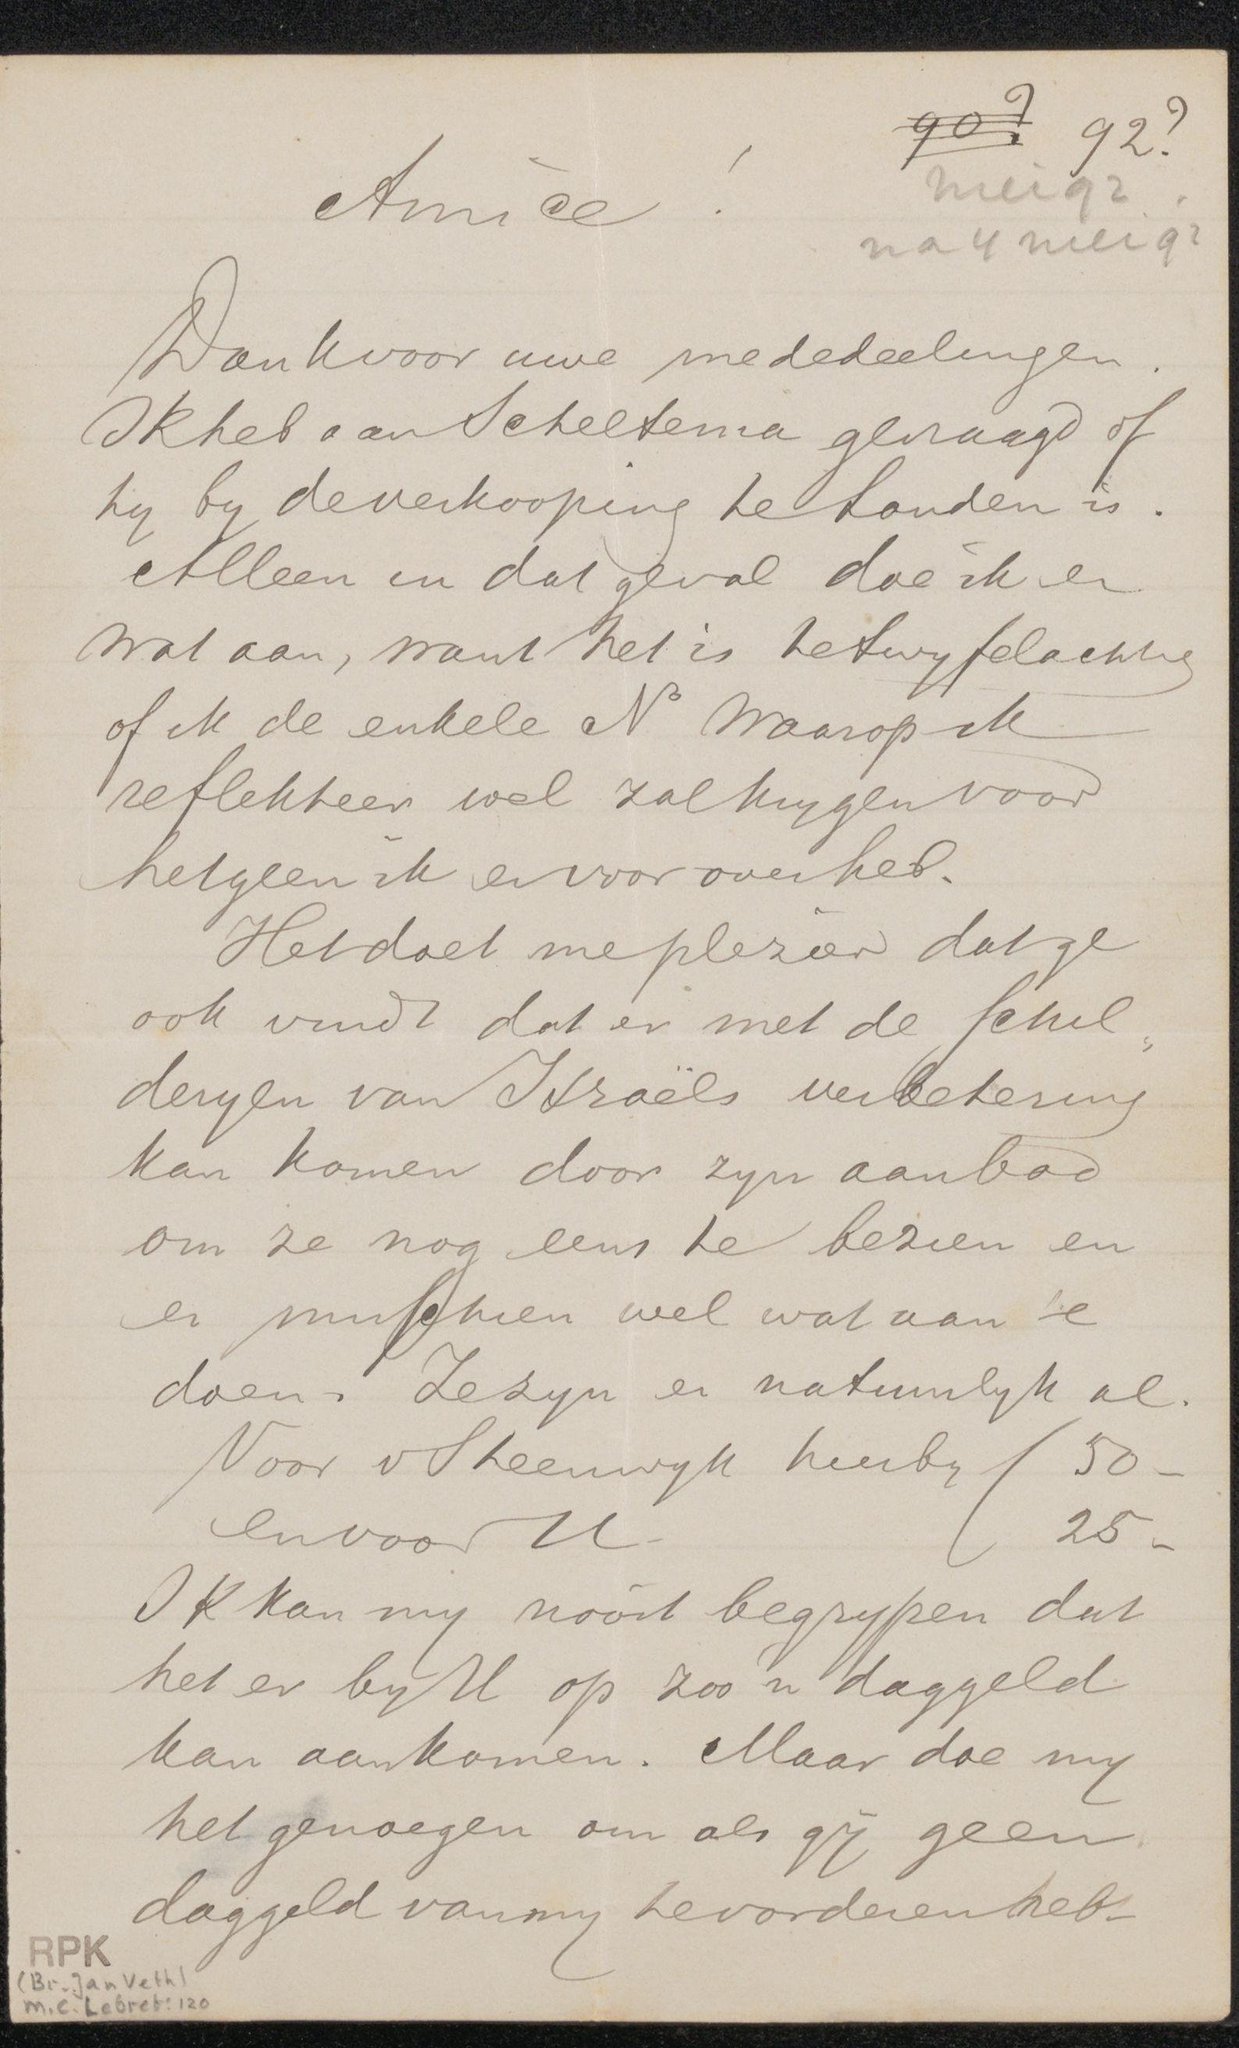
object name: letter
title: Brief aan Jan Veth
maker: martinus cornelis lebret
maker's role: verzamelaar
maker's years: 1833-1894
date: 1892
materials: ink, paper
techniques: pen, writing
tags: painter, print maker, draughtsman, jozef israëls, dordrecht, amsterdam, designer, jan veth, art trade, art shop, painting (including book-illumination, miniature-painting), diseases, historical persons (portraits and scenes from the life), money, london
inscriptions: collector's mark: ‘RPK’